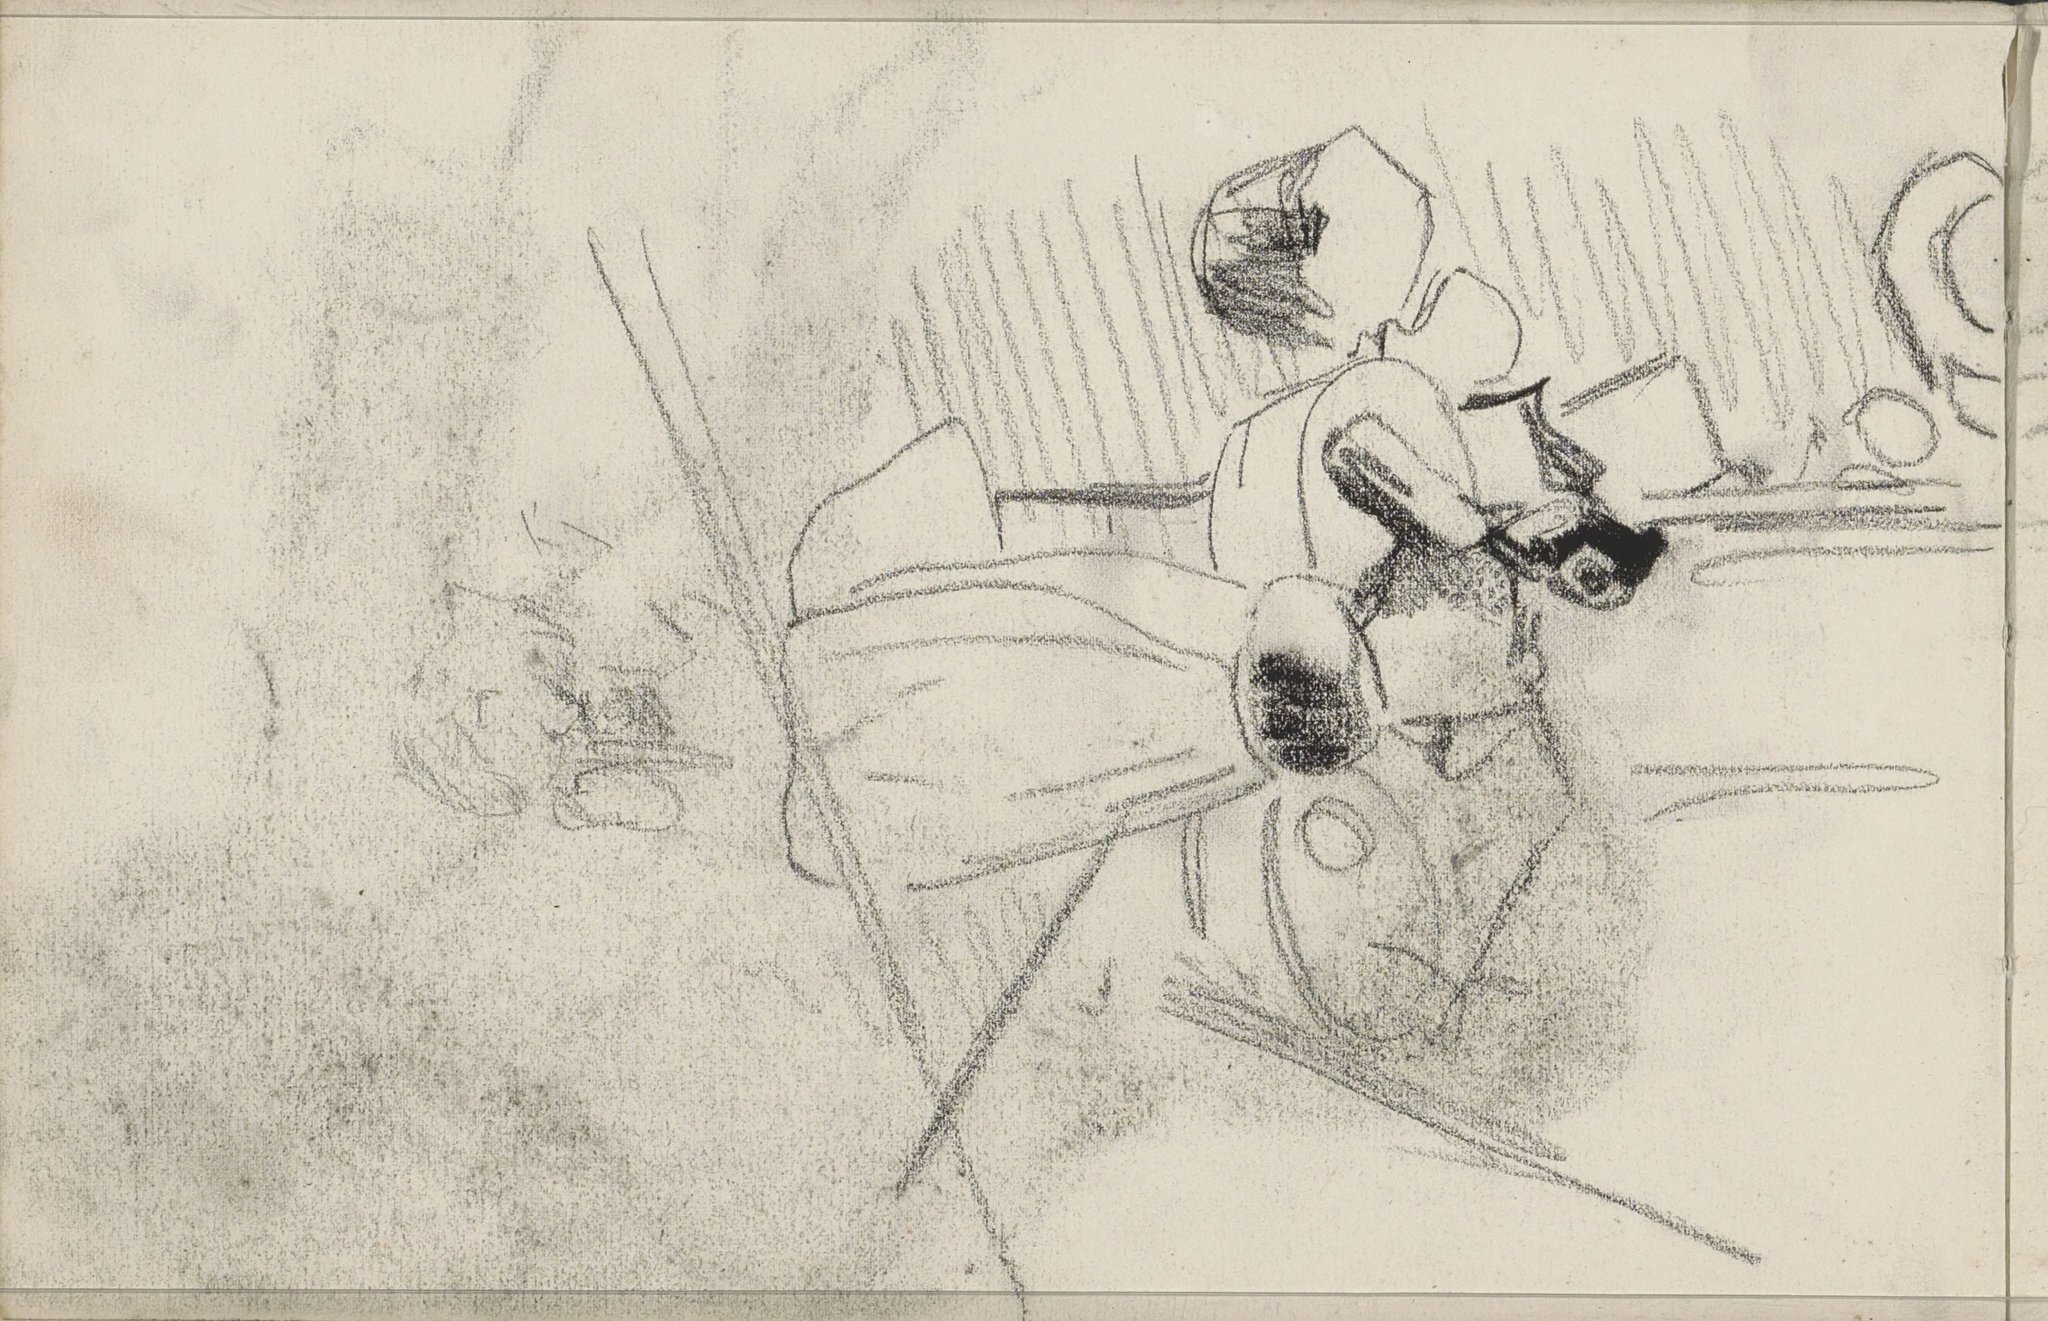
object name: sketchbook leaf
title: Vrouw in een interieur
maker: carel adolph lion cachet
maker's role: draughtsman, print maker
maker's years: 1864-1945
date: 1895-1900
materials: chalk, paper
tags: interior of the house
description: De vrouw staat voorovergebogen, vermoedelijk bij een tafel. Blad 18 verso uit een schetsboek met 19 bladen.